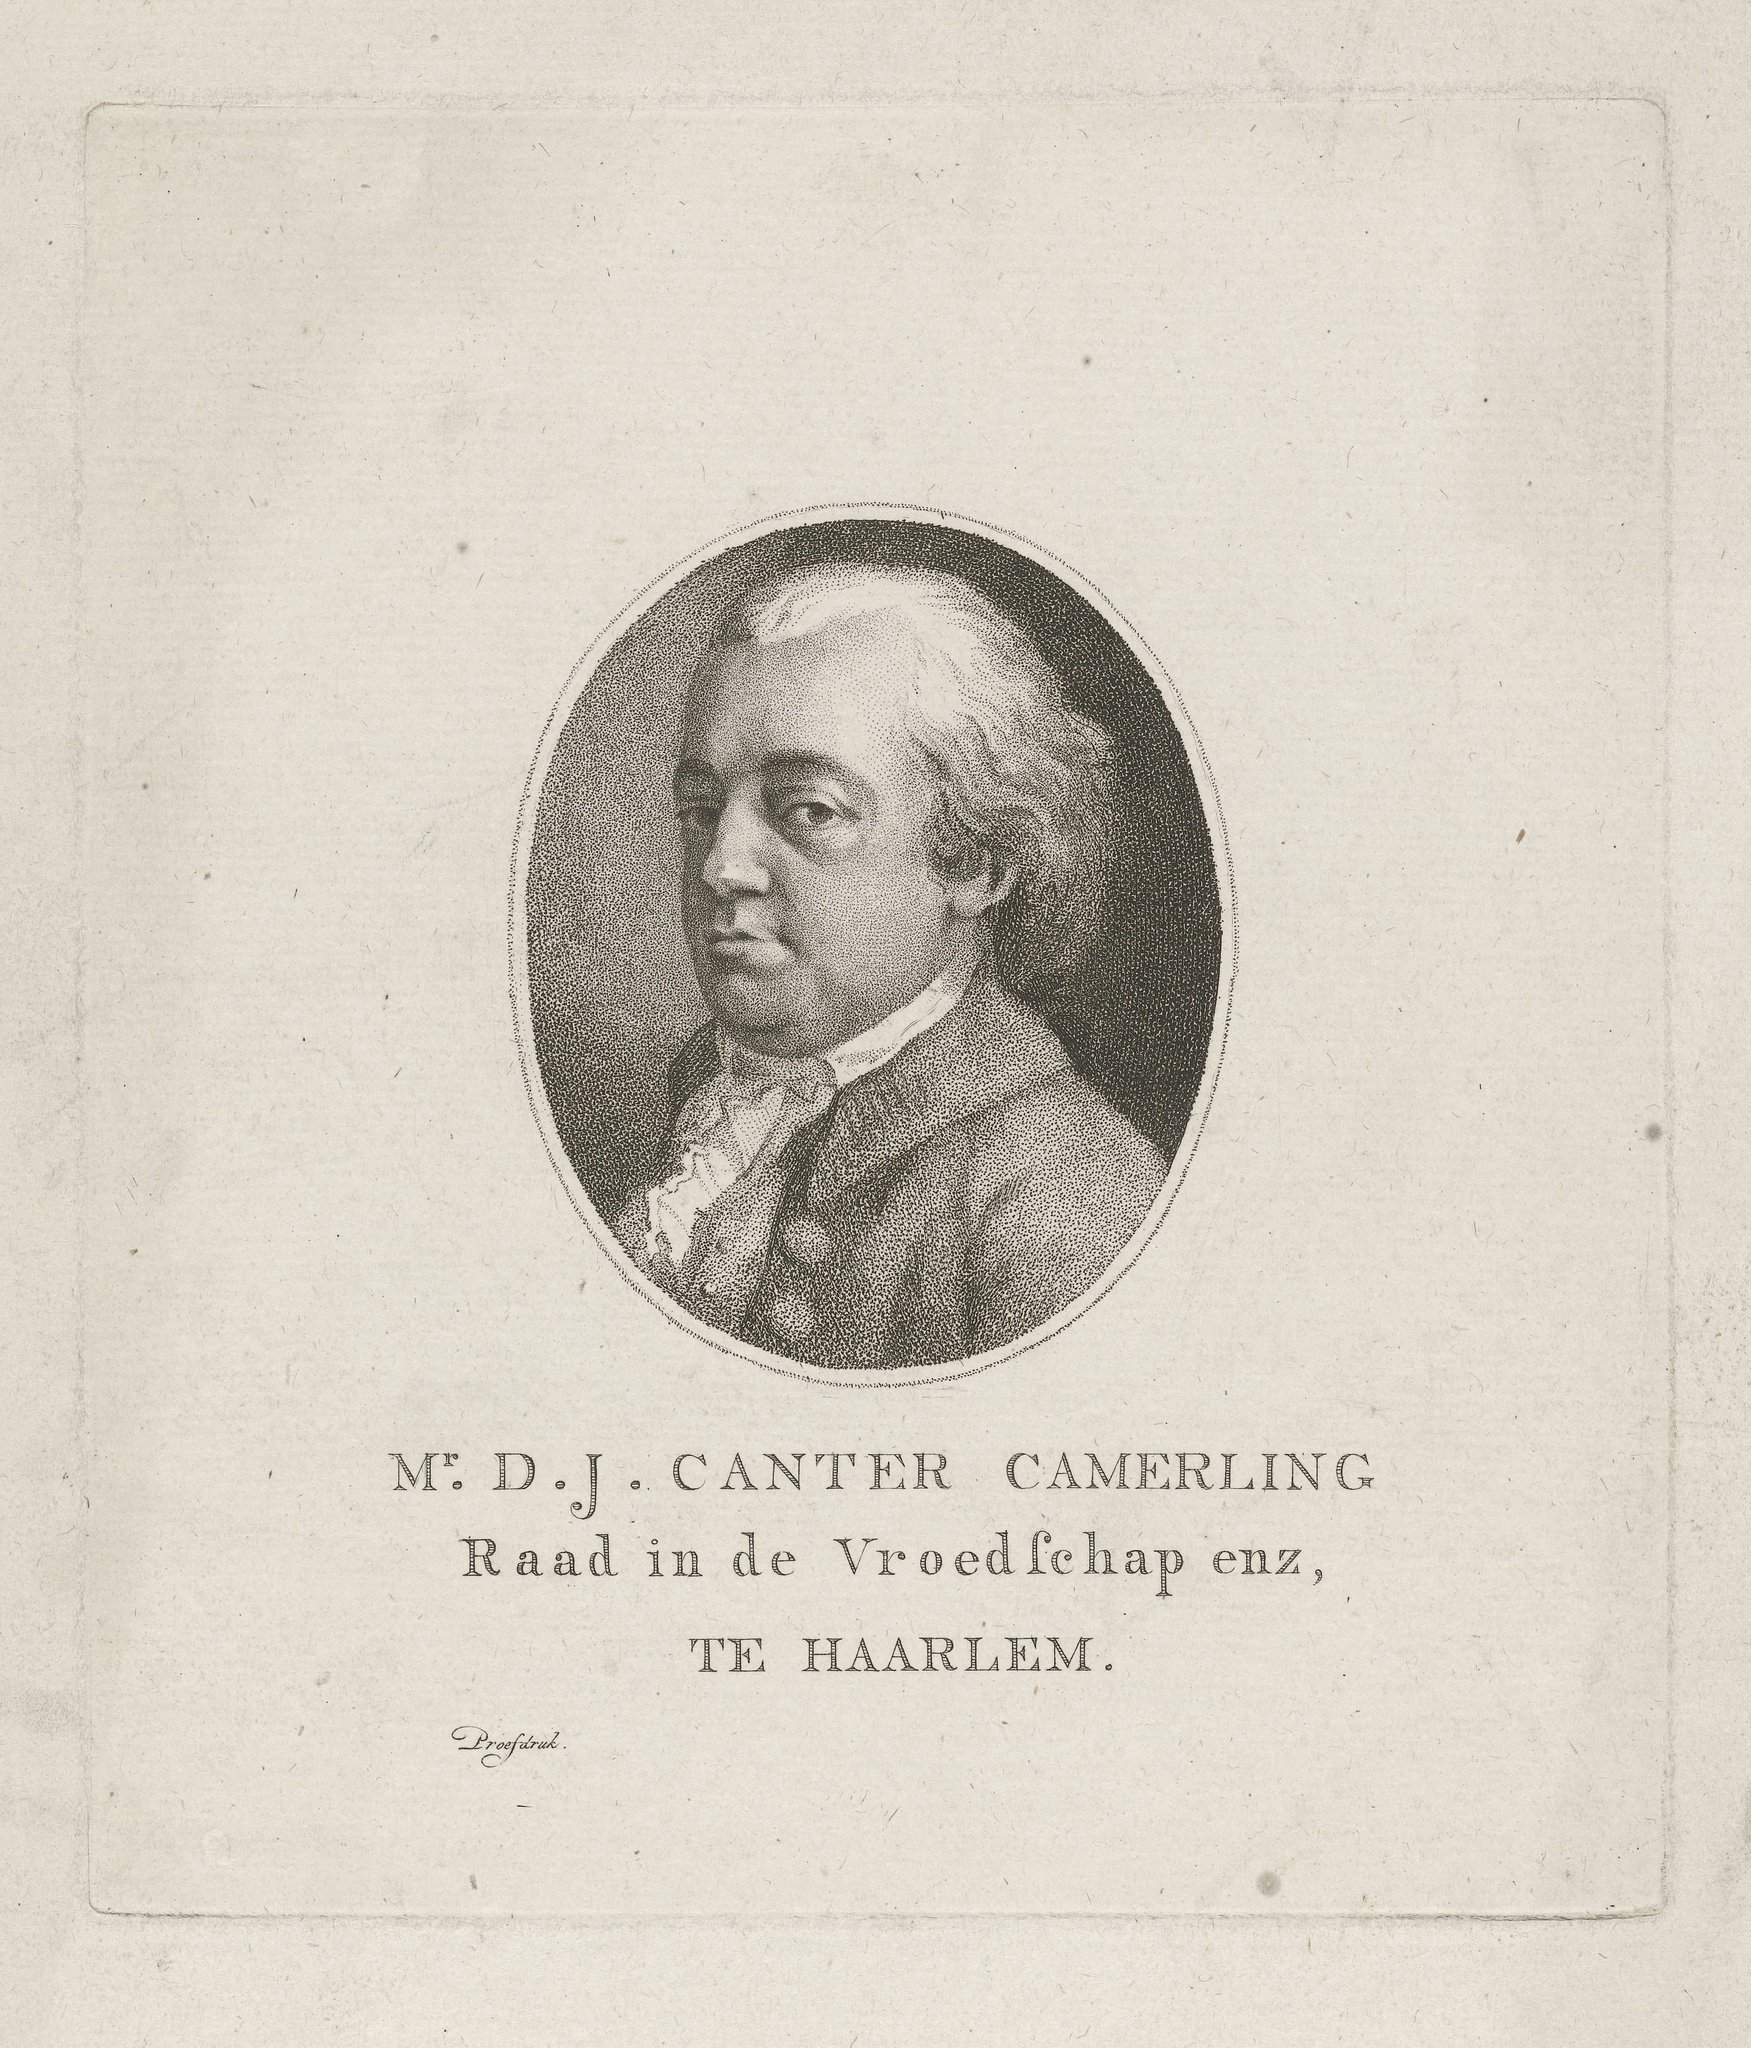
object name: print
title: Mr. D.J. Canter Camerling Raad in de Vroedschap enz, te Haarlem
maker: jan kobell (i)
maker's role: draughtsman, print maker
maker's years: 1756-1833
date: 1766-1833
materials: paper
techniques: etching, engraving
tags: haarlem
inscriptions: collector's mark: Lugt 2228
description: Portretbuste van Daniël Jacobus Canter Camerling, burgemeester te Haarlem.